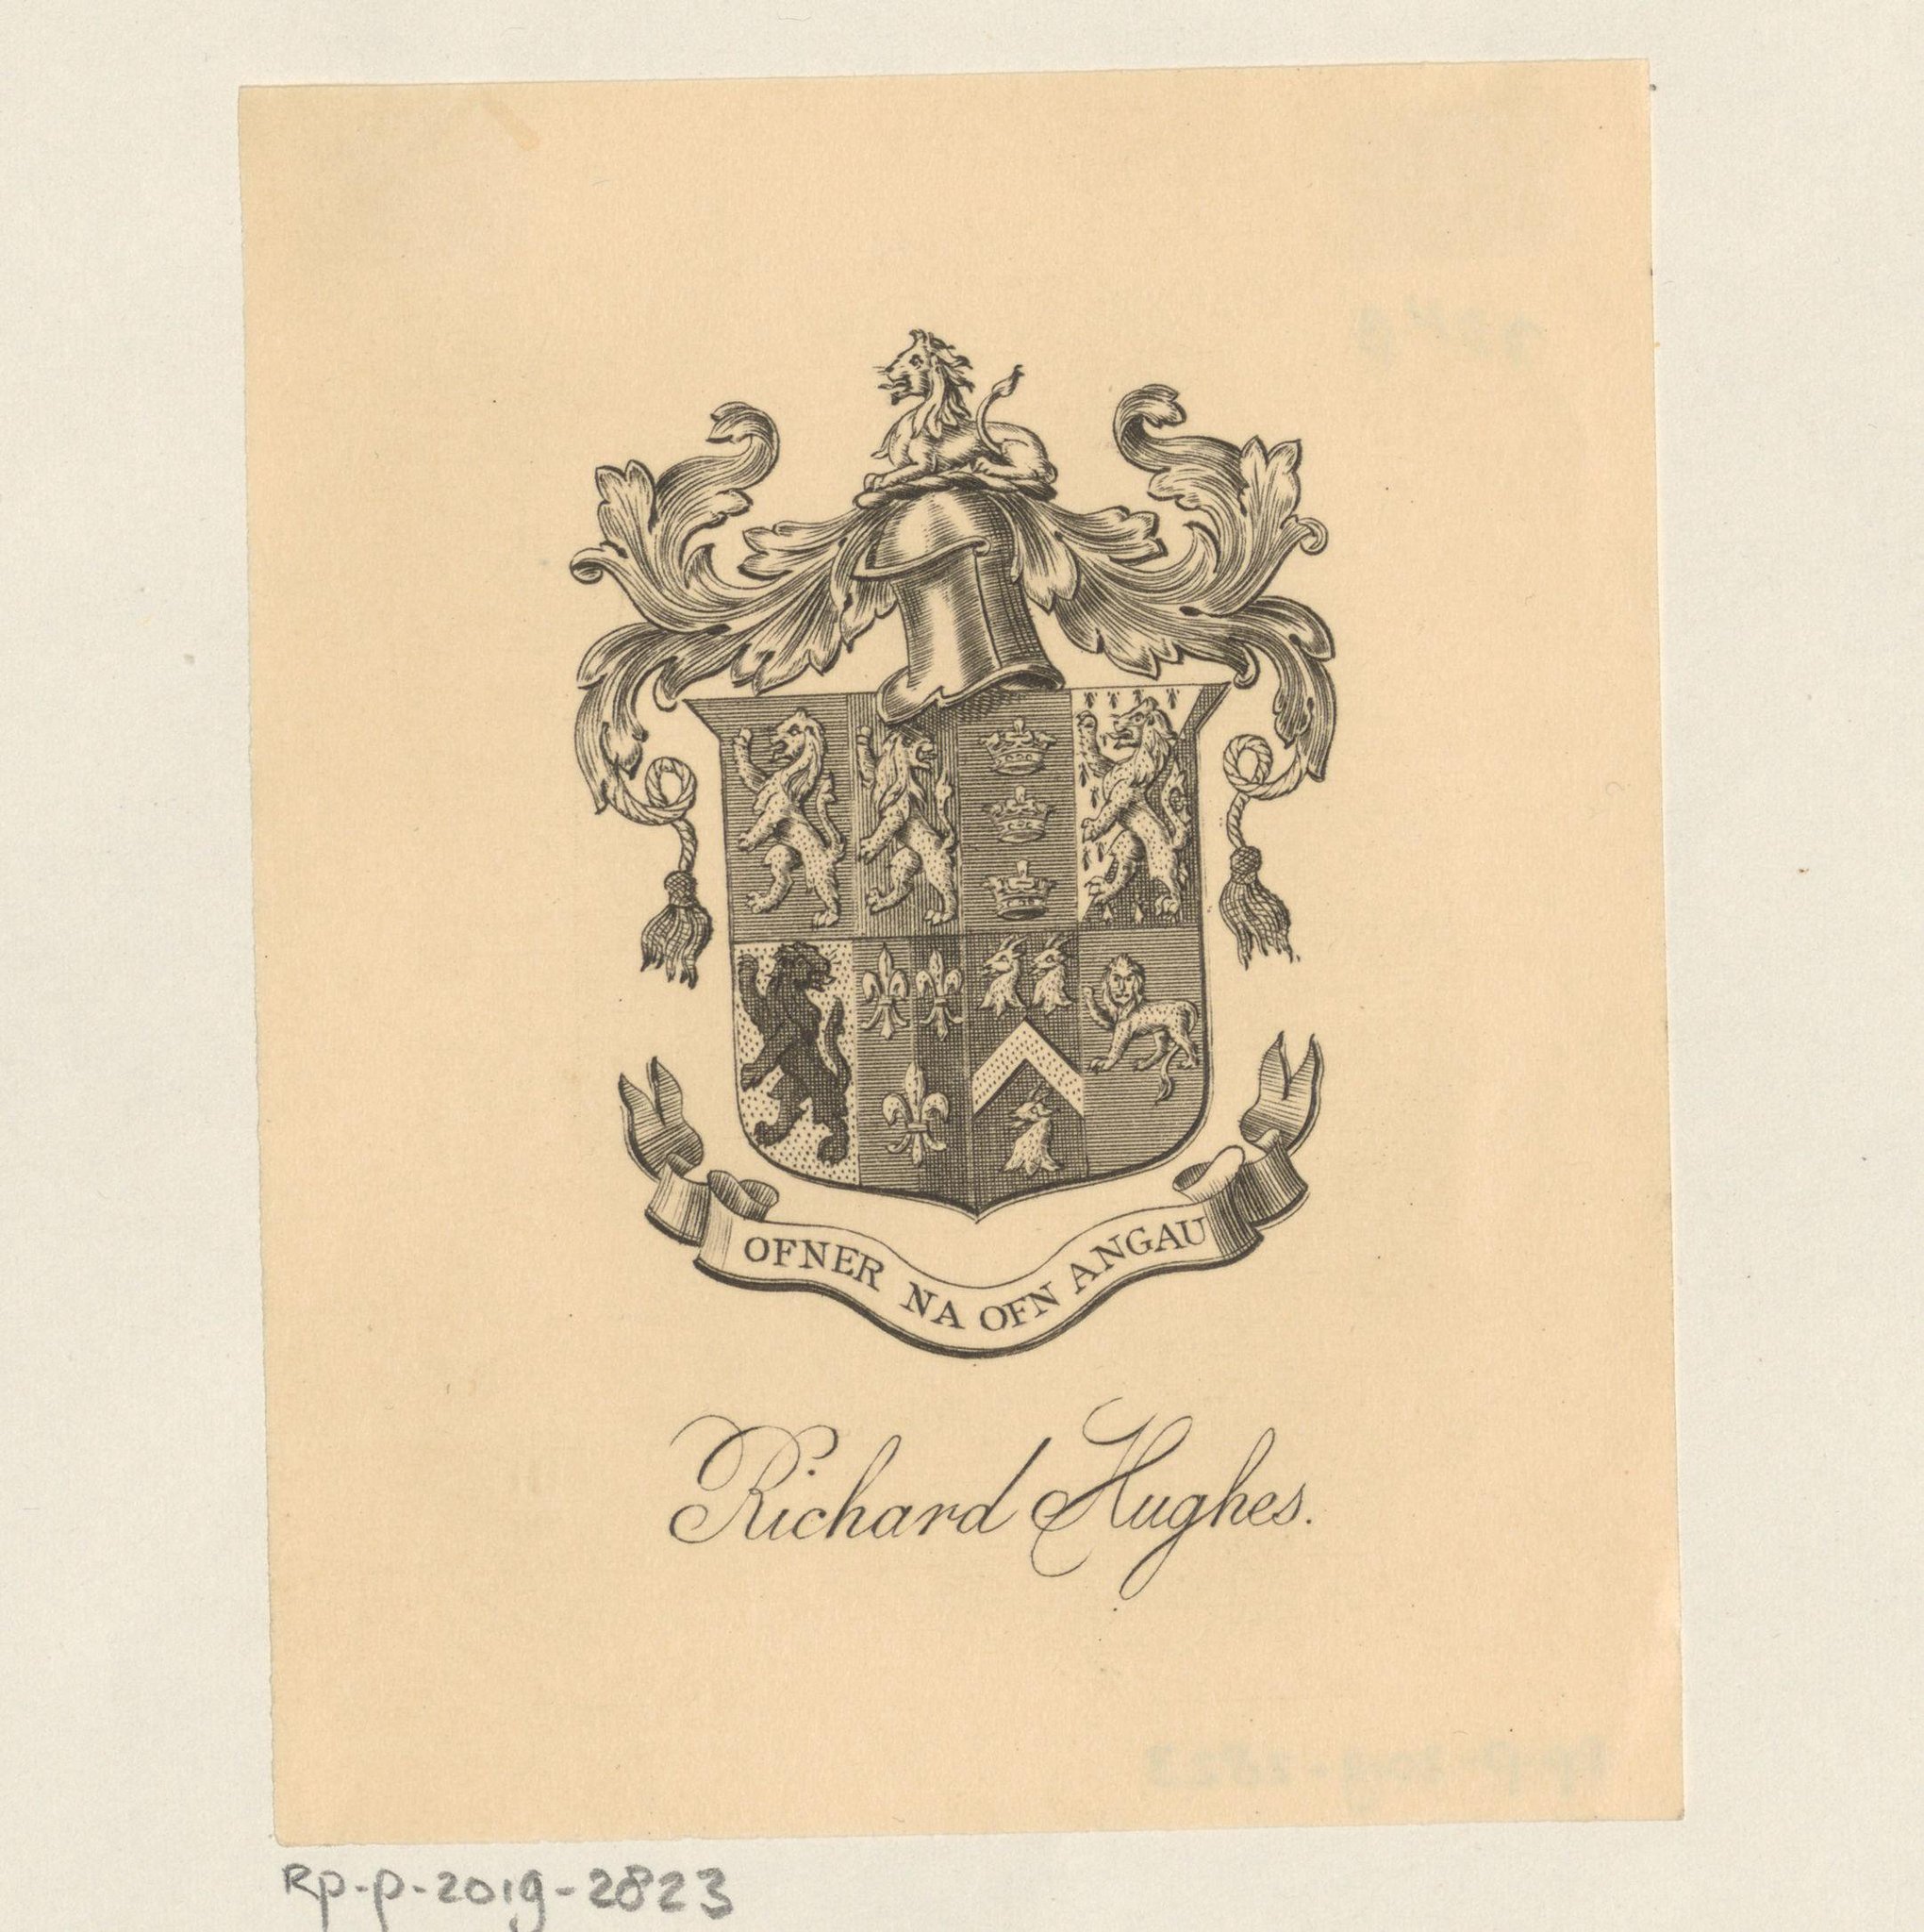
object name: bookplate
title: Ofner na ofn angau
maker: Anonymous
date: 1908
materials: paper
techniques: engraving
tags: armorial bearing, heraldry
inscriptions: date